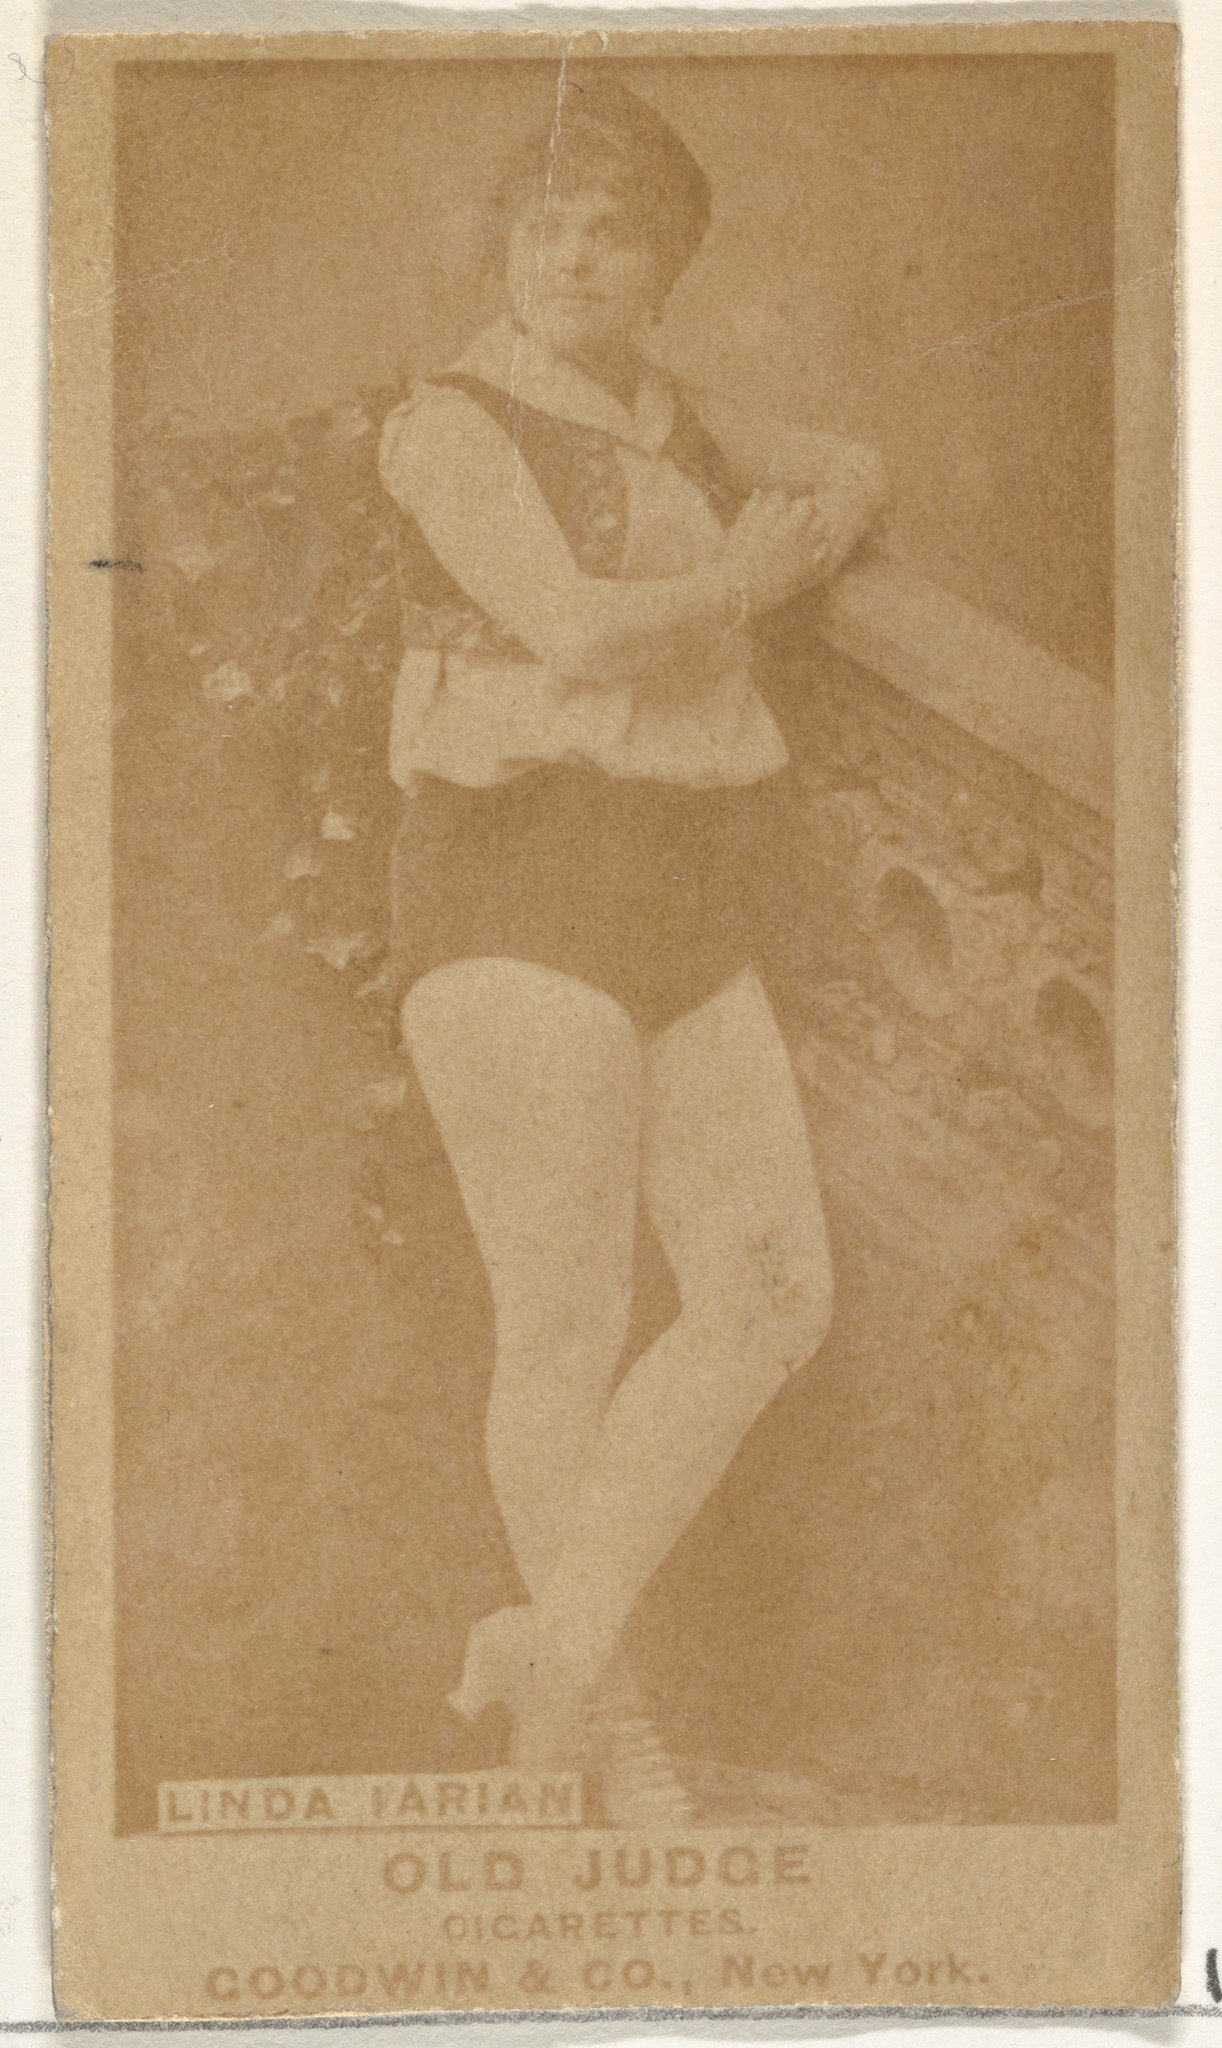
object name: photograph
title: Linda Farian, from the Actors and Actresses series (N171) for Old Judge Cigarettes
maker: goodwin & company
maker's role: publisher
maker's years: 1850-1950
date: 1886-1890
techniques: albumen silver print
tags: portraits,women,actresses